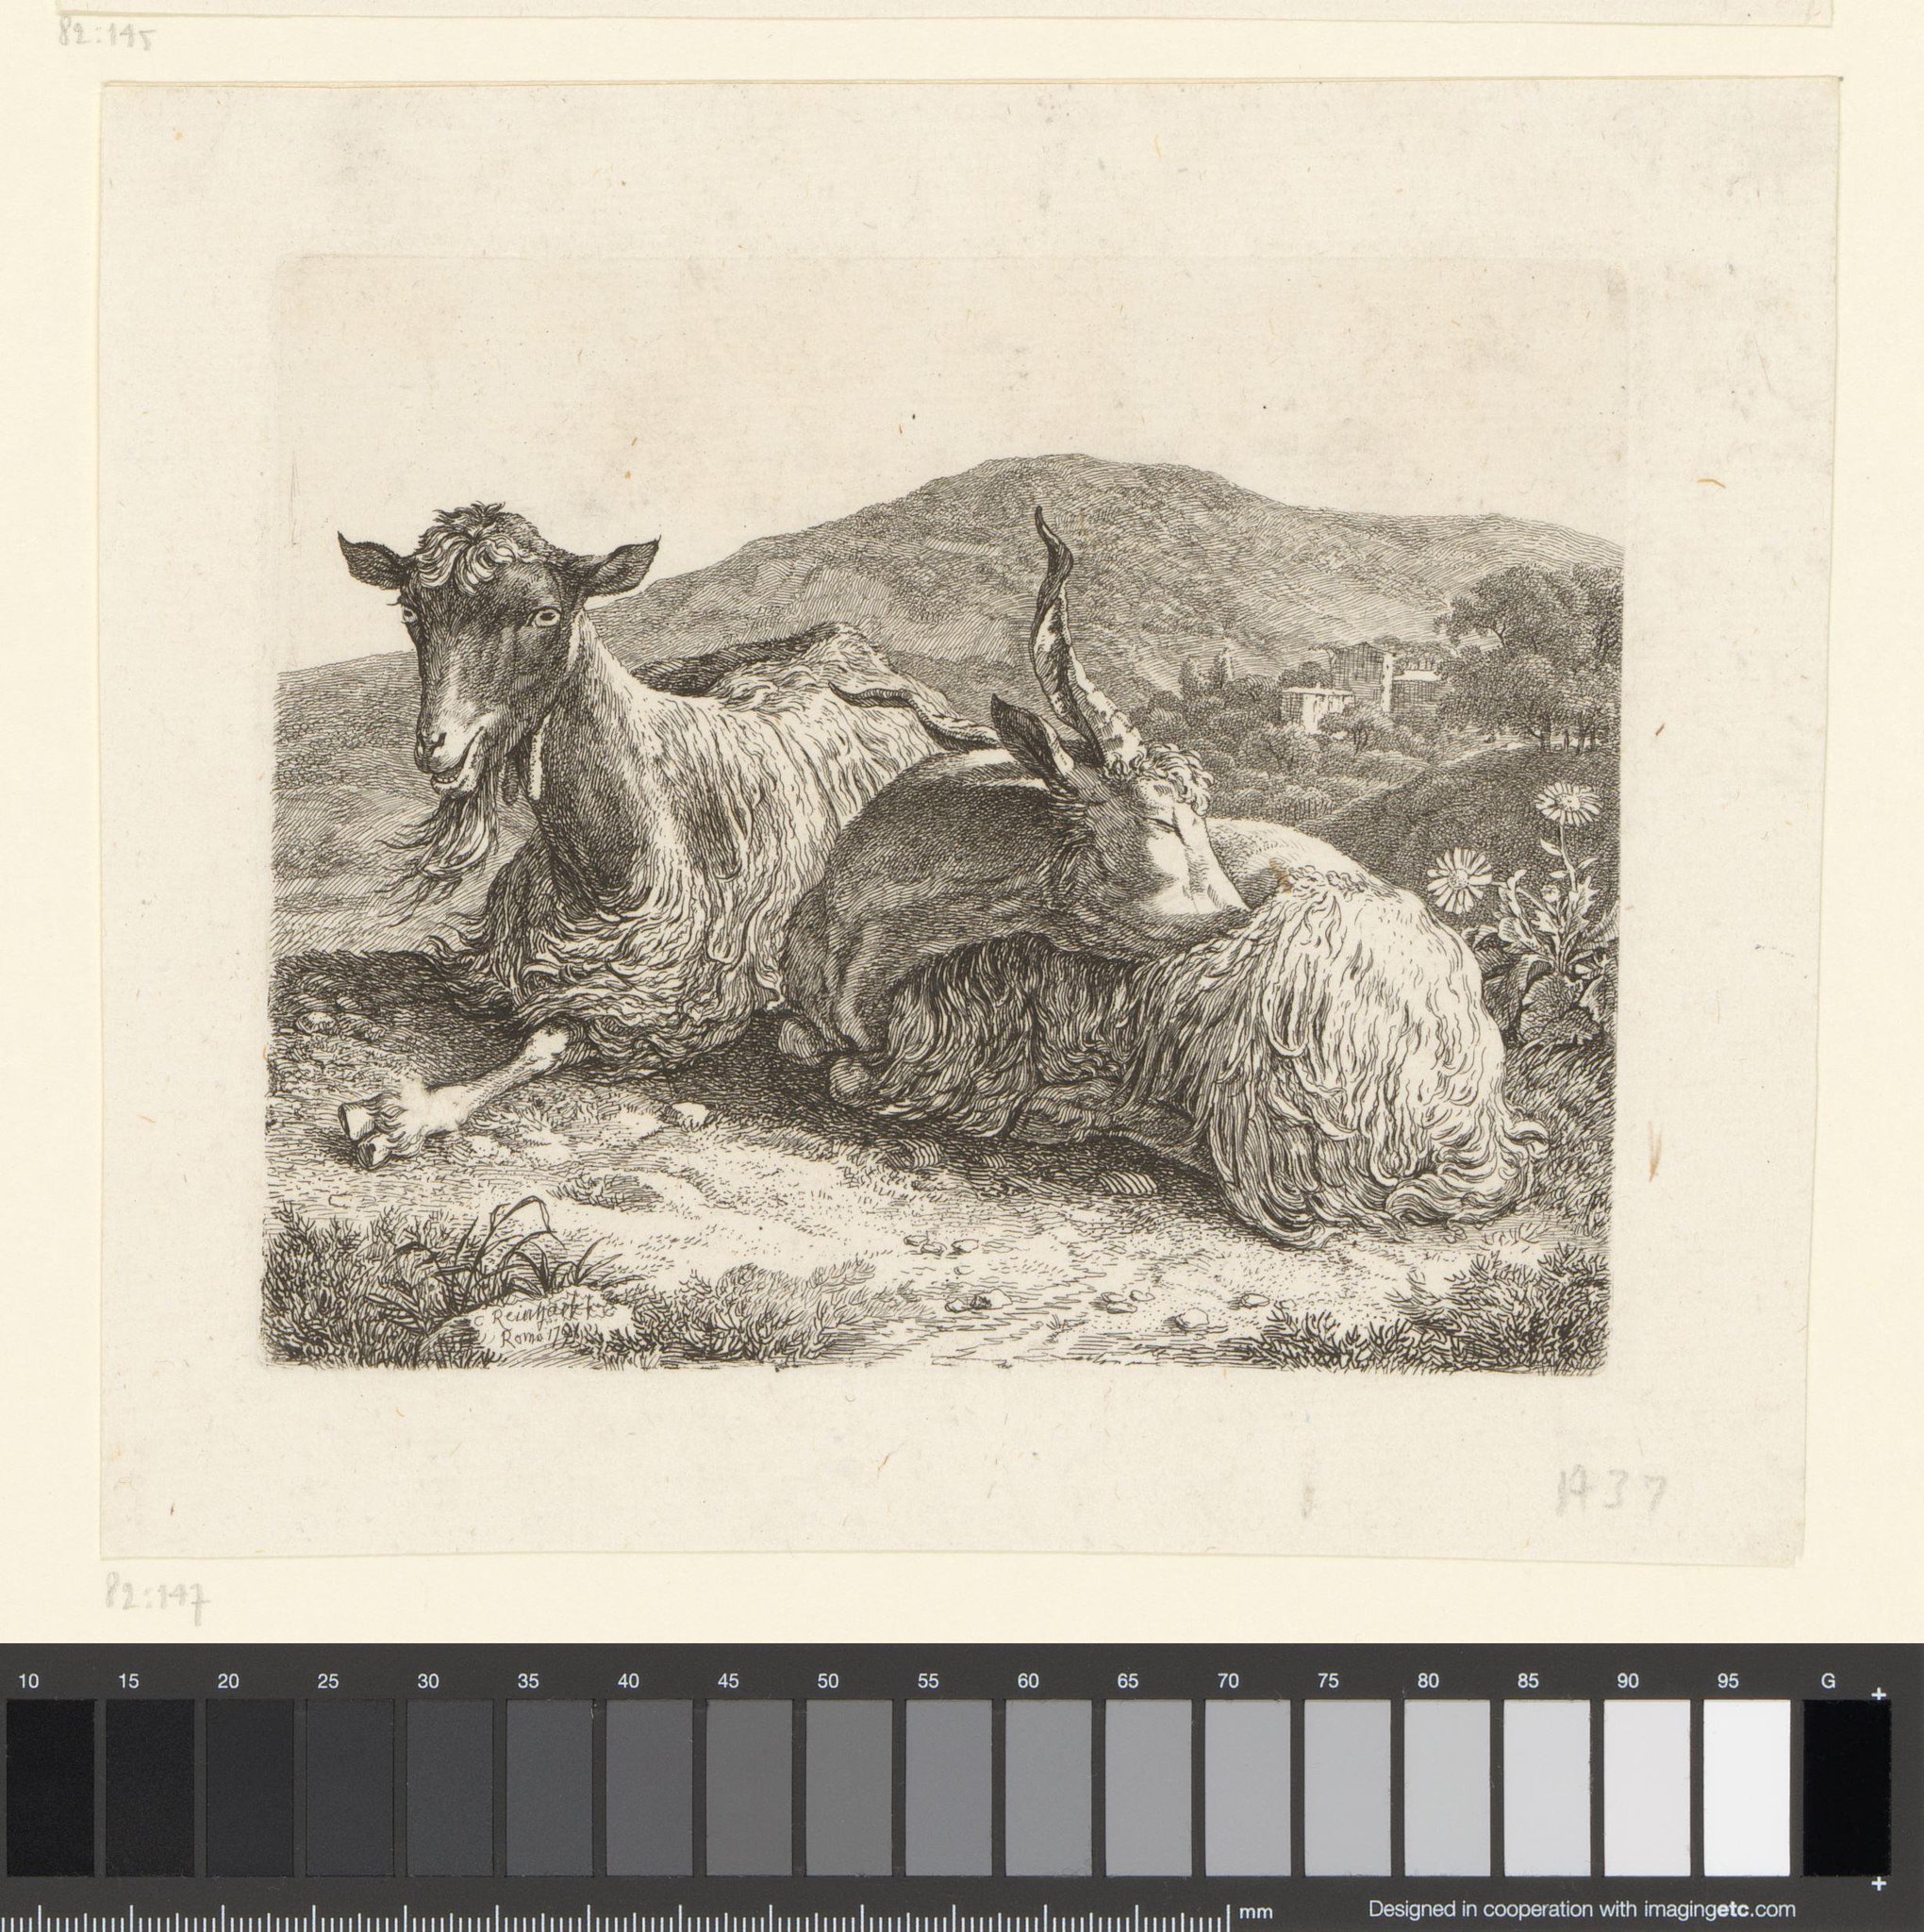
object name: print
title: Liggende geit en bok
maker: johann christian reinhart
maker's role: print maker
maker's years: 1761-1847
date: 1791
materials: paper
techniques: etching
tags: landscapes, goat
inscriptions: collector's mark: Lugt 2760, collector's mark: Lugt 2228